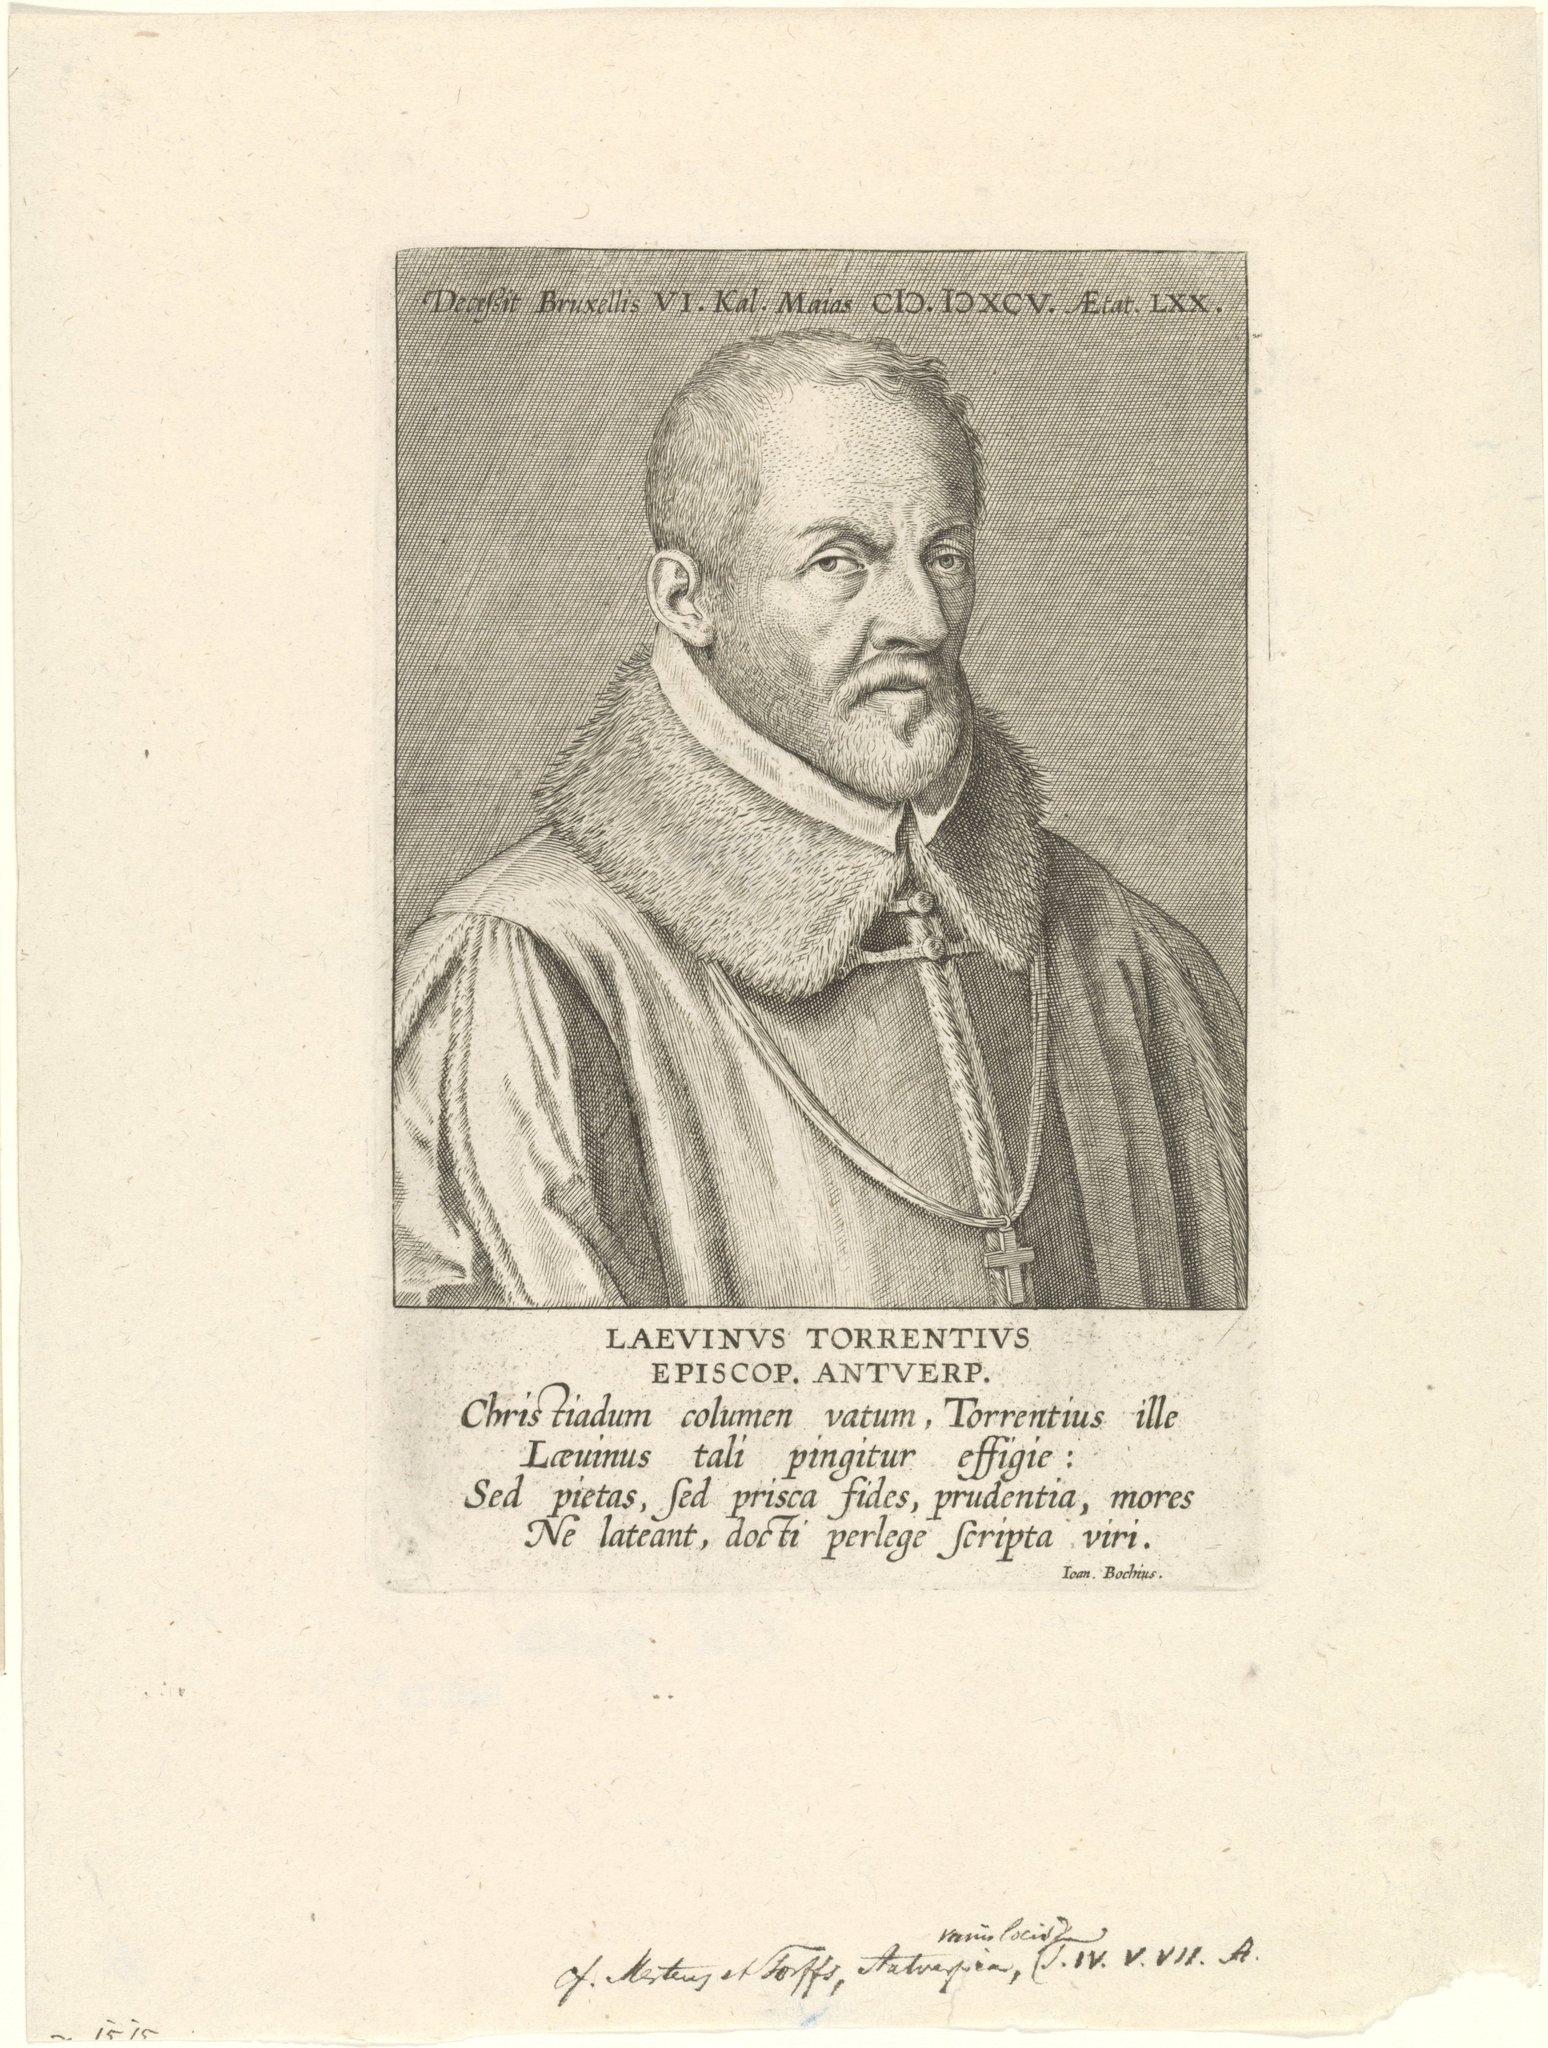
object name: print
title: Portret van Laevinus Torrentius, bisschop van Antwerpen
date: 1638-1678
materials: paper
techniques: engraving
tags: ghent, brussels, laevinus torrentius, archbishop, bishop, etc. (roman catholic)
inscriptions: collector's mark: Lugt 2228